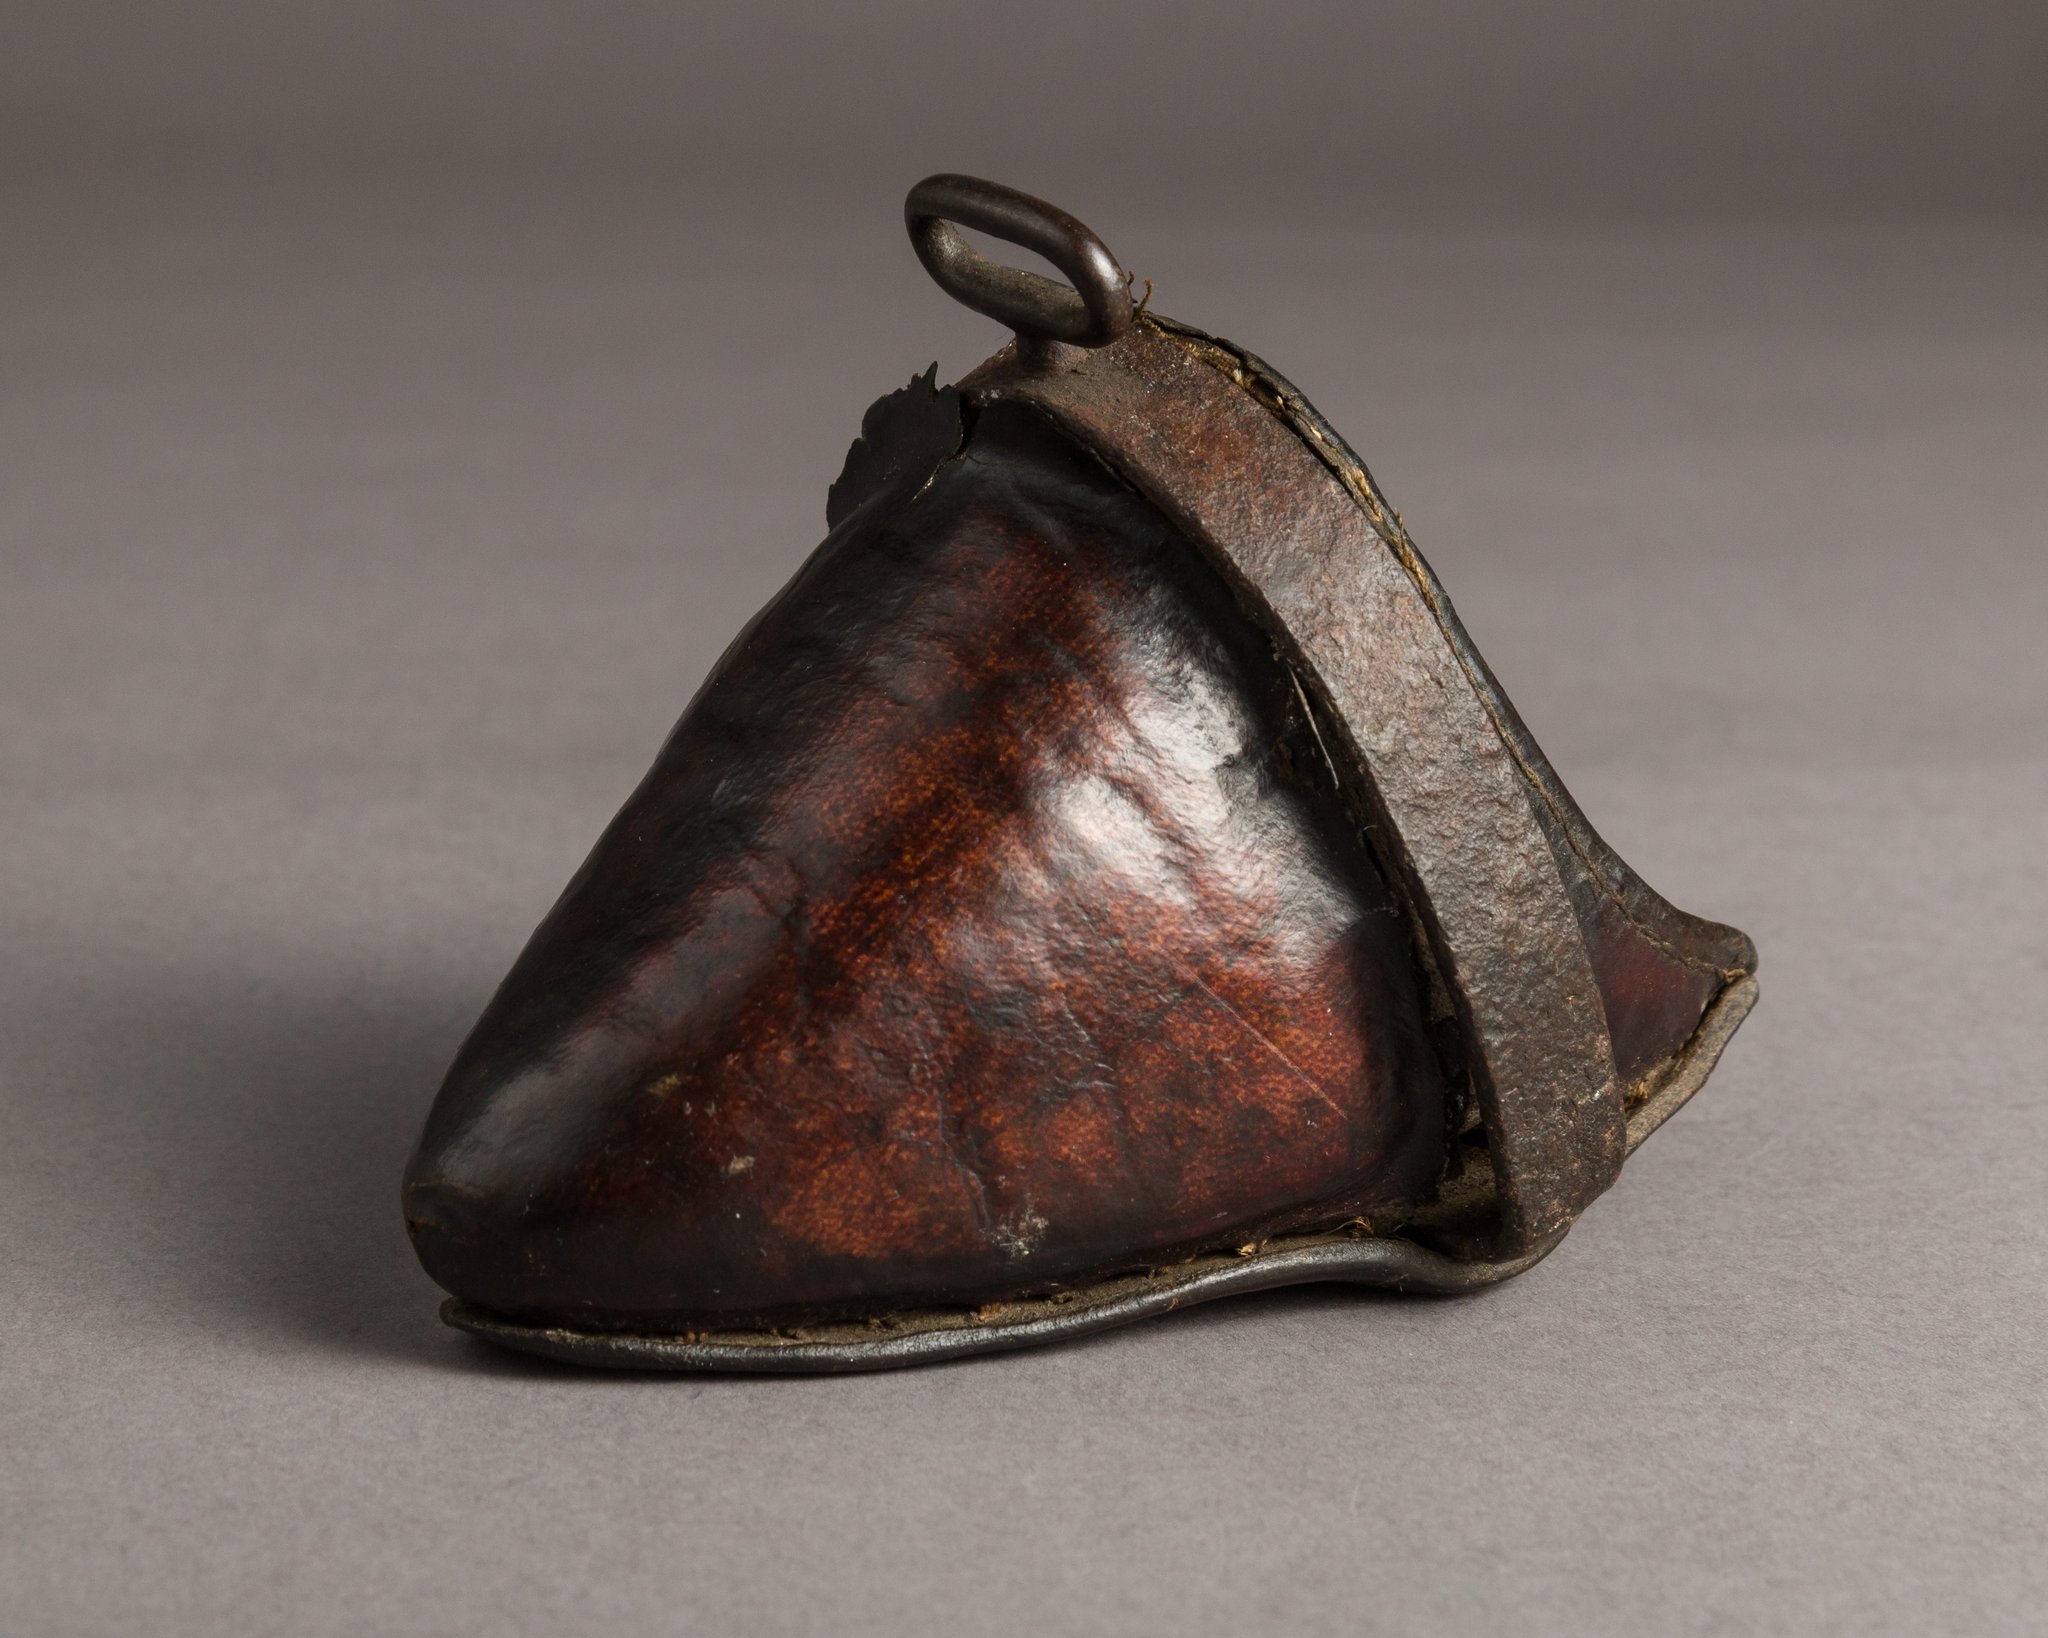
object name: stirrup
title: Lady's Stirrup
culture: french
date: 1767-1900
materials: iron, leather, thread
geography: france